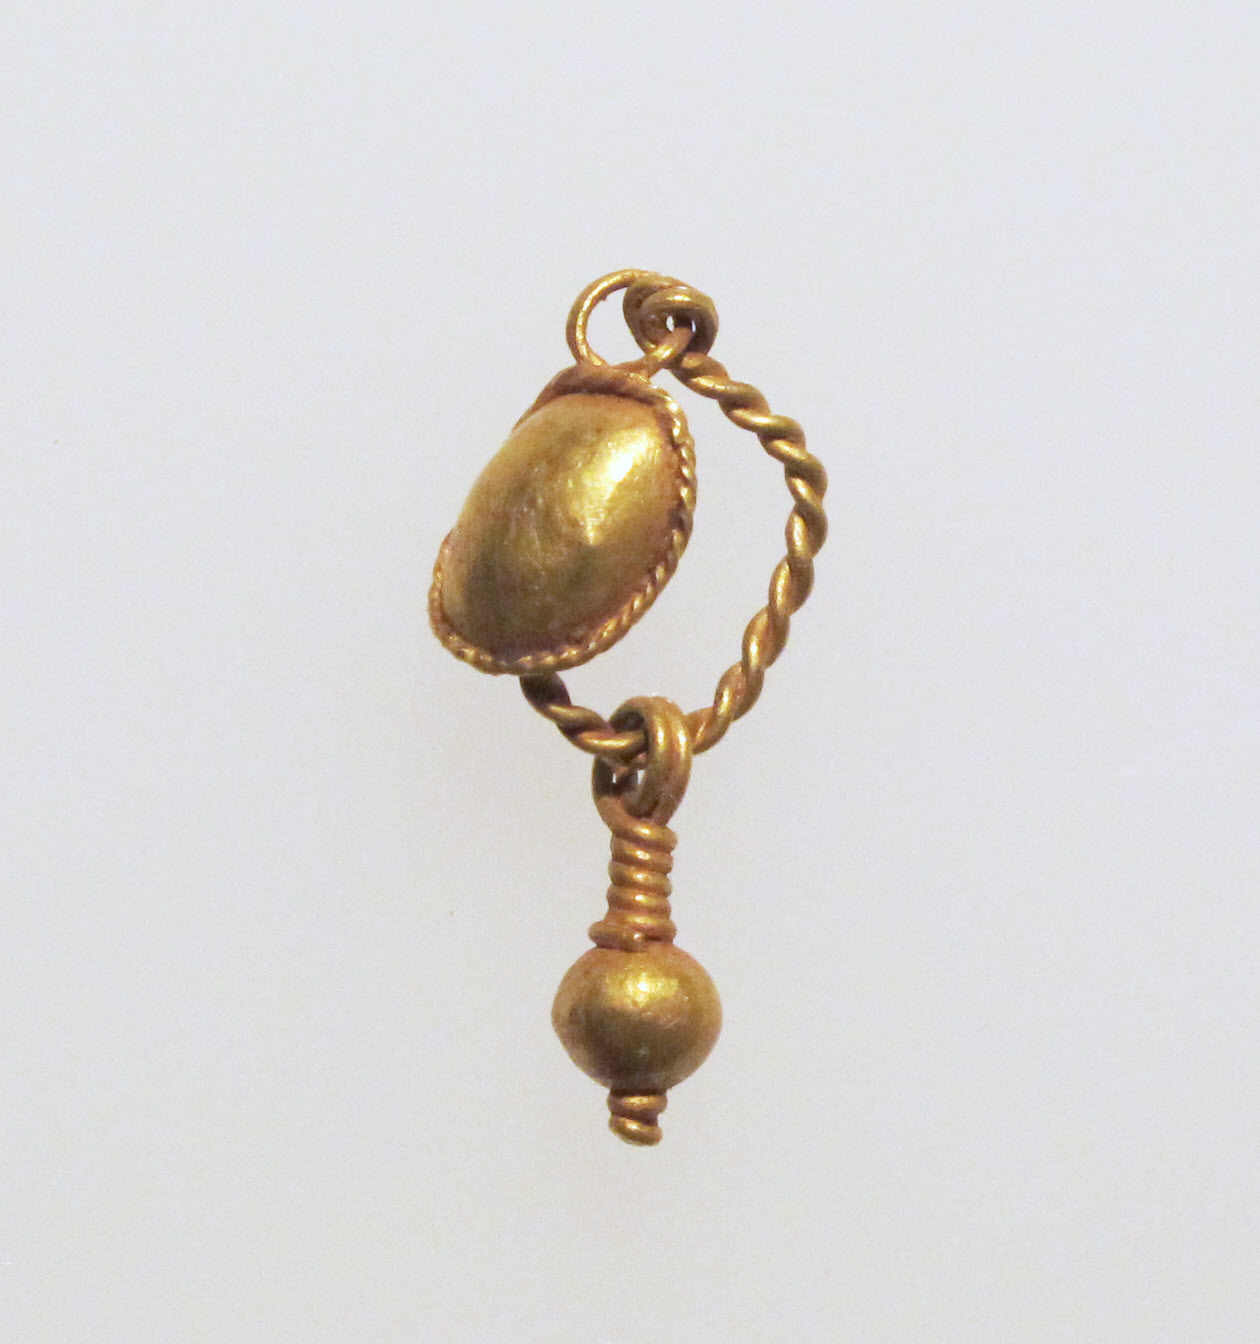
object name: earring with pendant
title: Gold earring with disc and pendant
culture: roman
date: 101-200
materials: gold